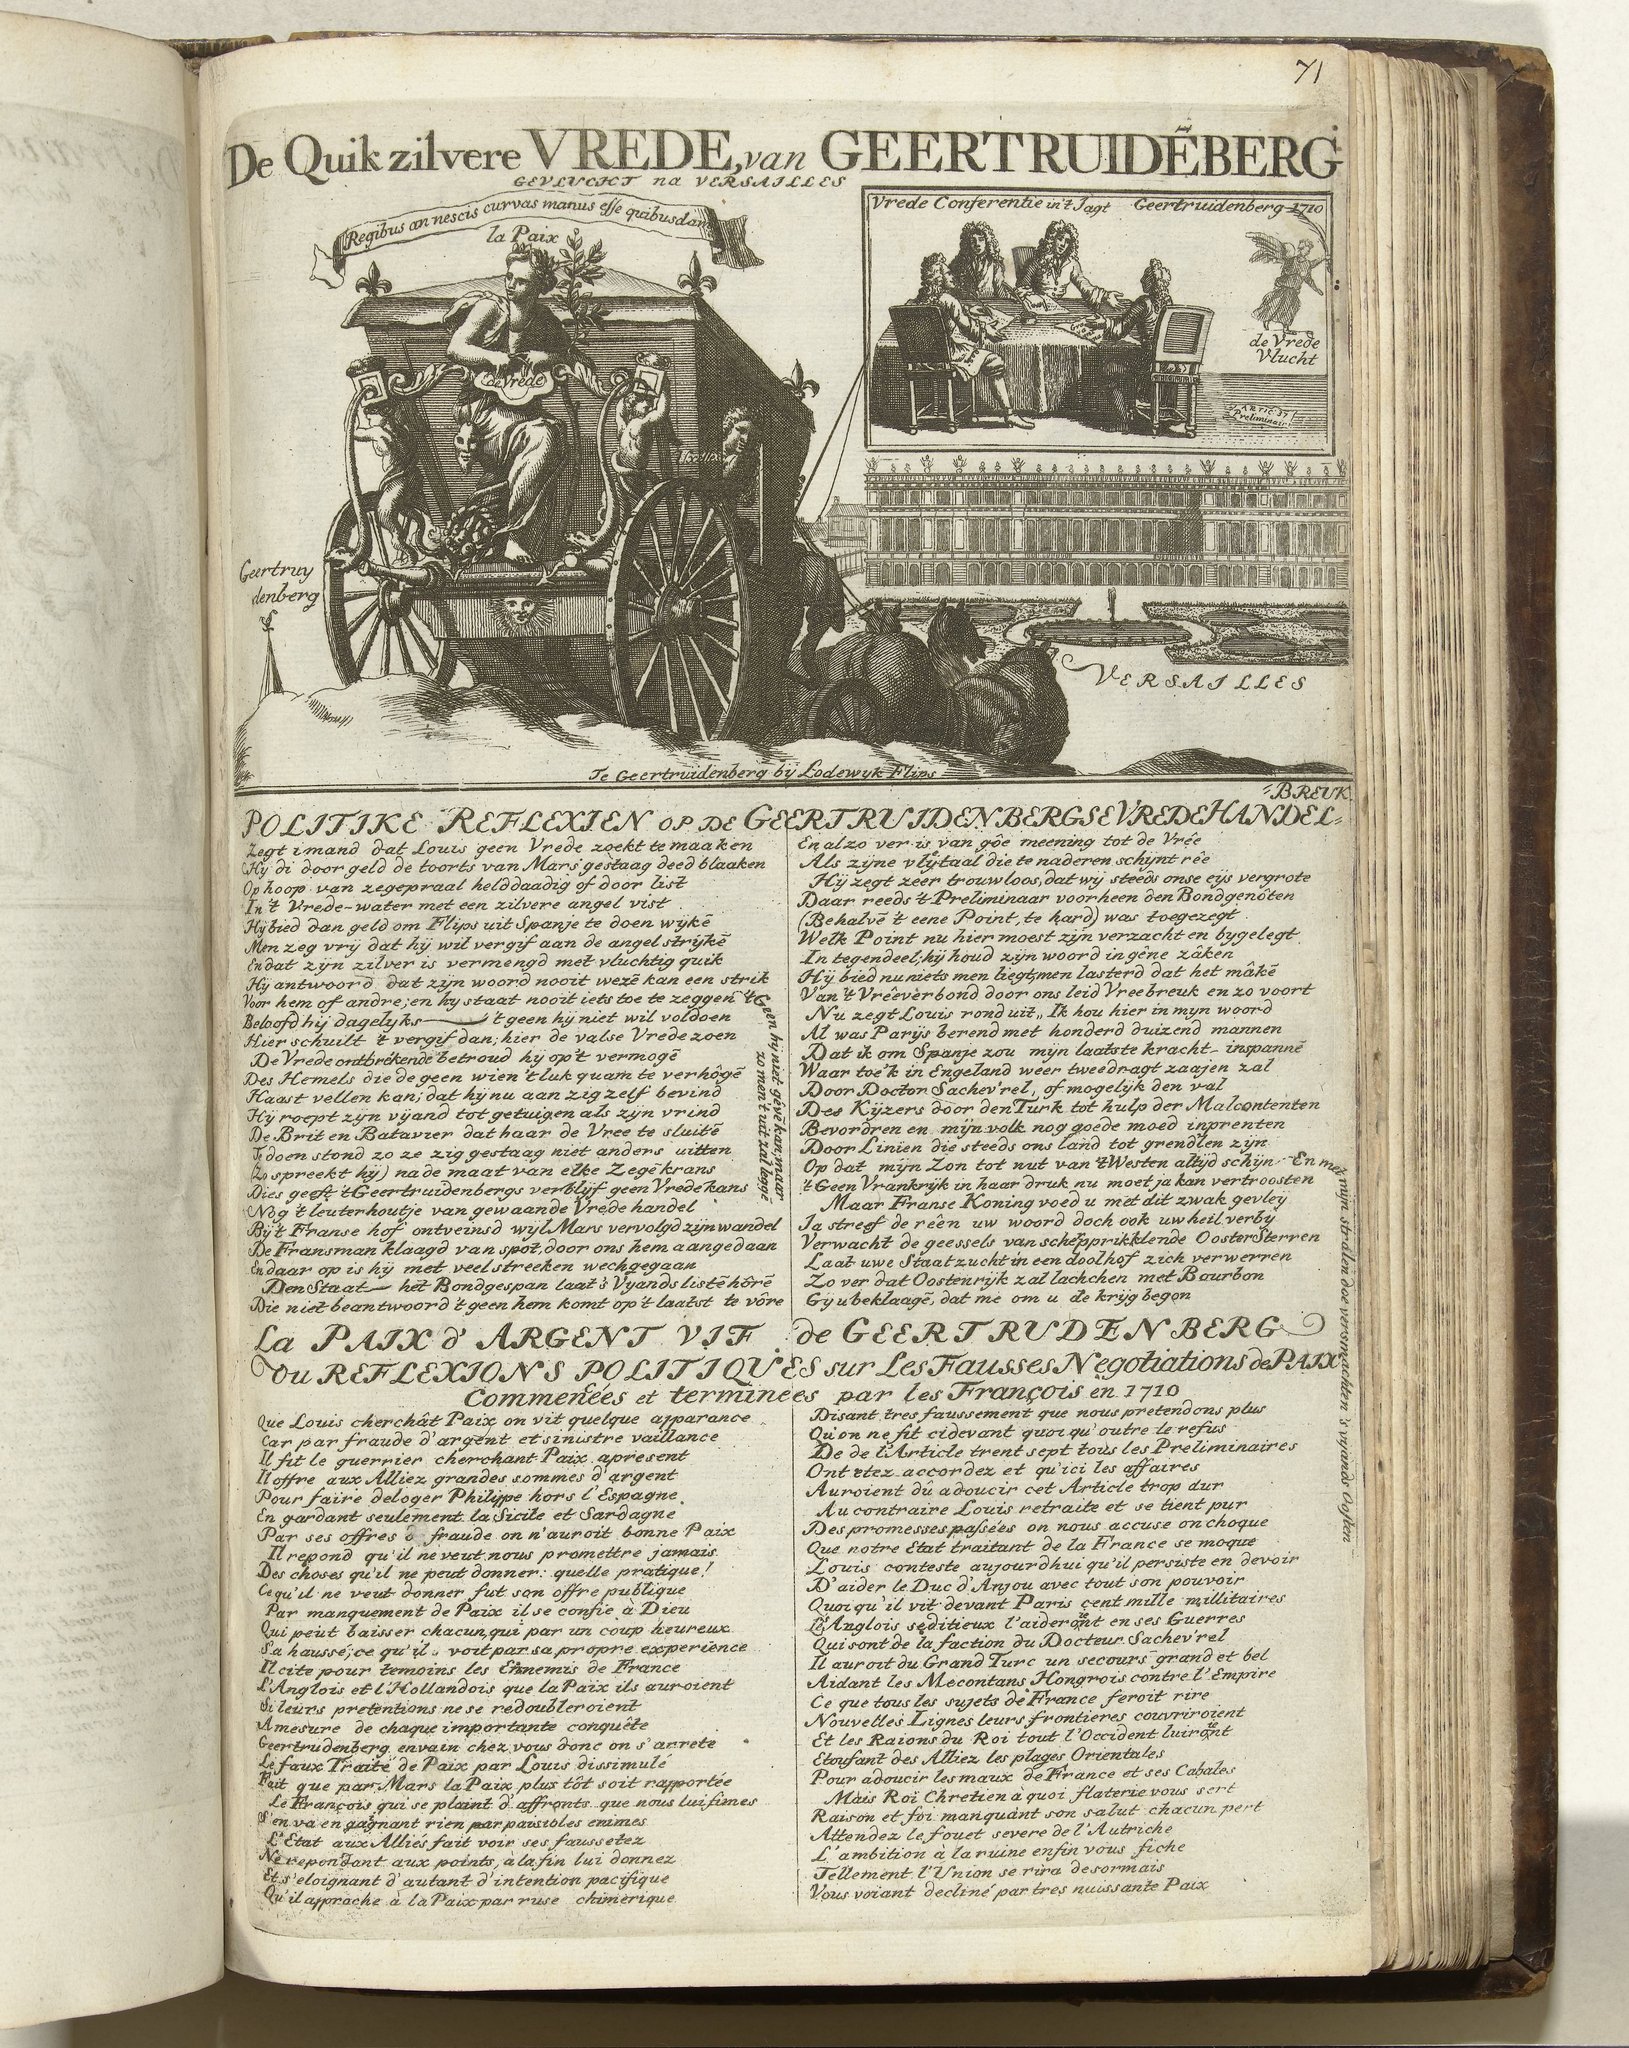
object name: print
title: De Quikzilvere Vrede, van Geertruide[n]berg gevlucht na Versailles / La Paix Argent vif de Geertudenberg (...)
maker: abraham allard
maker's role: print maker, publisher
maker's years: 1676-1725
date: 1710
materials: paper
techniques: etching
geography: amsterdam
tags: symbols, allegories of peace, 'pax'; 'pace' (ripa)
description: Allegorie op het mislukken van de vredesonderhandelingen tussen Frankrijk en de geallieerden, begonnen op 9 maart 1710 in een jacht en voortgezet te Geertruidenberg. De Vrede achterop een rijtuig dat naar het paleis van Versailles rijdt. Met opschriften en verzen in het Nederlands en Frans. Ongenummerd. Door Muller (incorrect) opgenomen als de zevende prent in de Vorstelyke Staat-Balans, een reeks van 7 genummerde spotprenten op de Fransen in het jaar 1709 van de Spaanse Successieoorlog. Onderdeel van het prentwerk uitgegeven onder de verzameltitel 't Lust-Hof van Momus met de gebundelde series van spotprenten tijdens de jaren 1701-1713 van de Spaanse Successieoorlog.